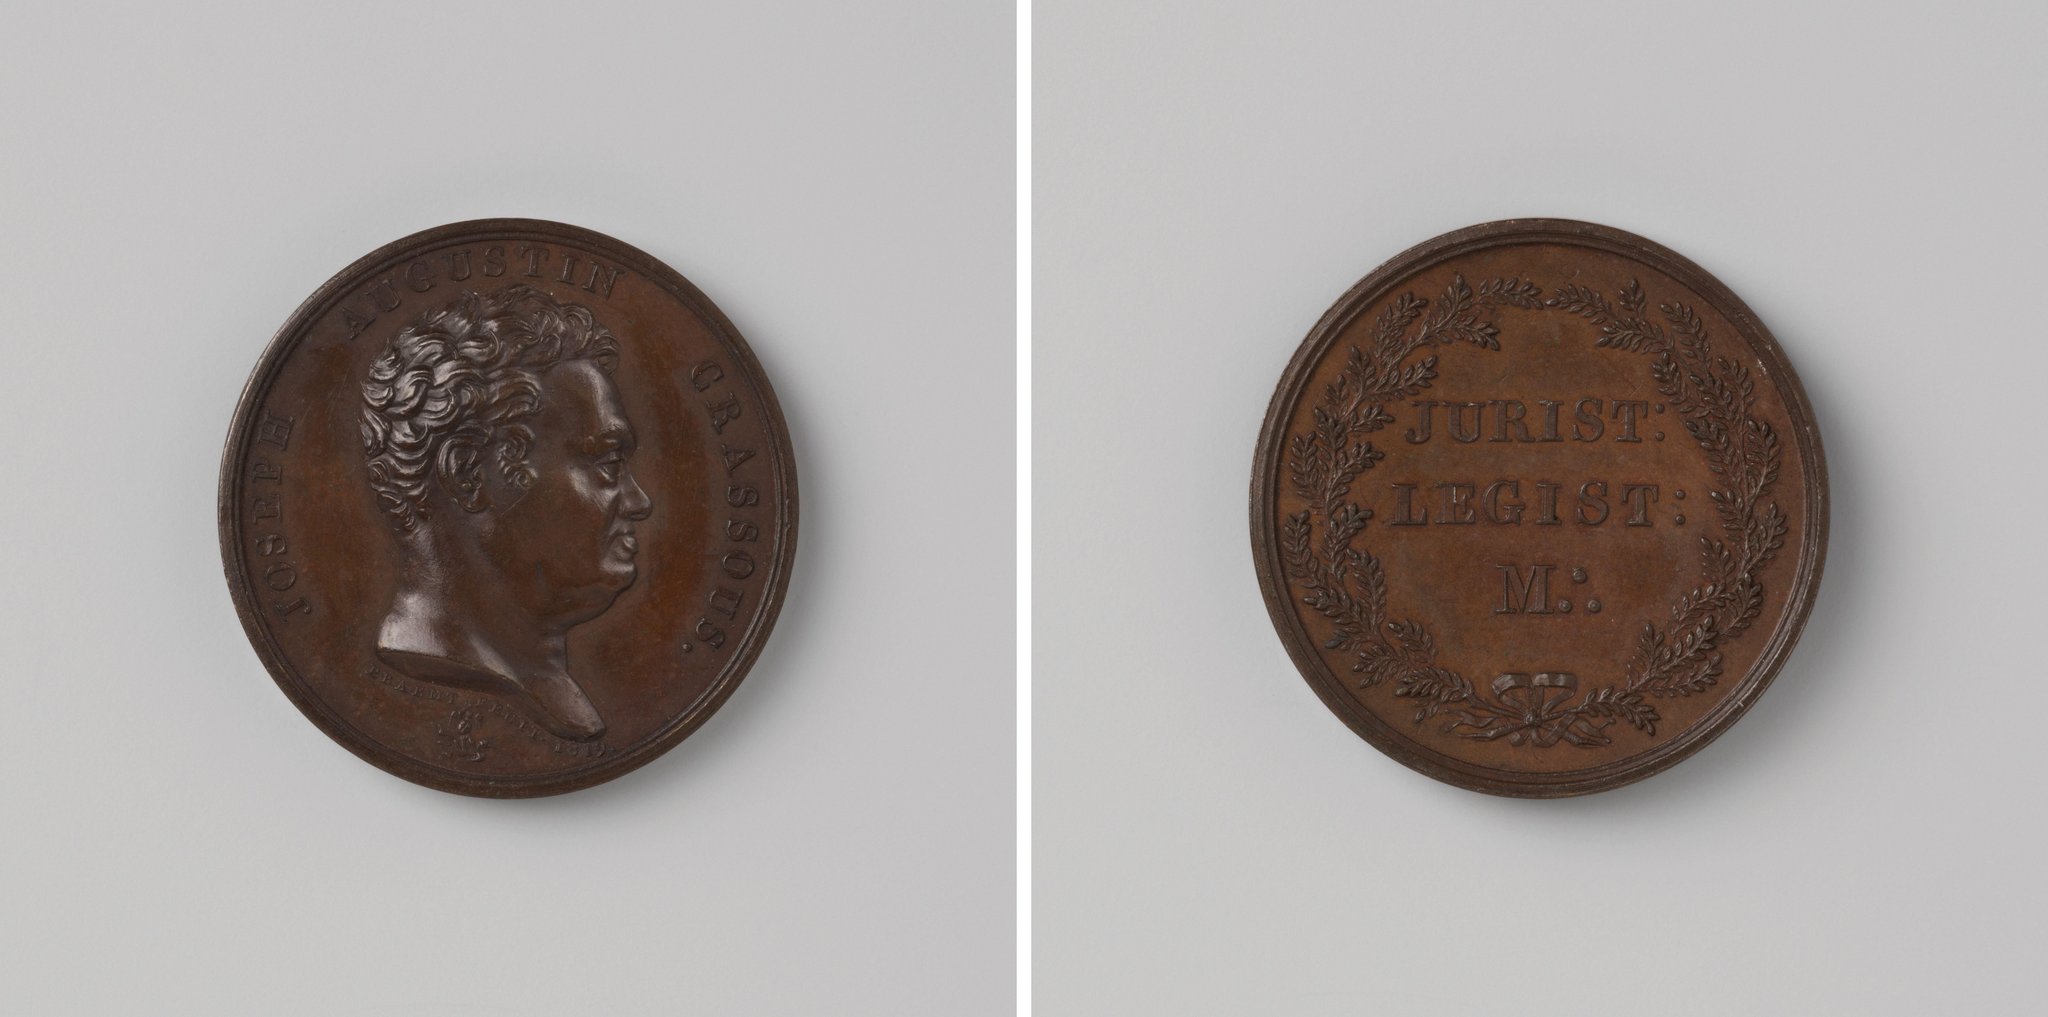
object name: history medal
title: J.A. Crassous, rechtsgeleerde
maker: joseph pierre braemt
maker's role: print maker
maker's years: 1796-1864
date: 1819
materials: bronze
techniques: striking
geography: brussels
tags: j.a. crassous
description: Bronzen penning. Voorzijde: borststuk man naar rechts binnen omschrift; onder afsnede: signatuur en St. Michael die ter aarde liggende draak doodt. Keerzijde: opschrift binnen krans van olijftakken